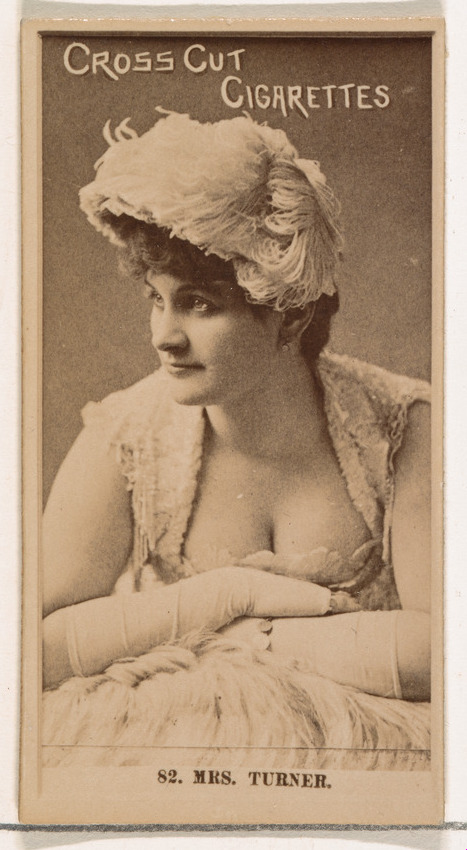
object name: print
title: Card Number 82, Mrs. Turner, from the Actors and Actresses series (N145-2) issued by Duke Sons & Co. to promote Cross Cut Cigarettes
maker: w. duke, sons & co.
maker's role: publisher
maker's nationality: american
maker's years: 1870-1920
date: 1880-1889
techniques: albumen silver print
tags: portraits,women,actresses